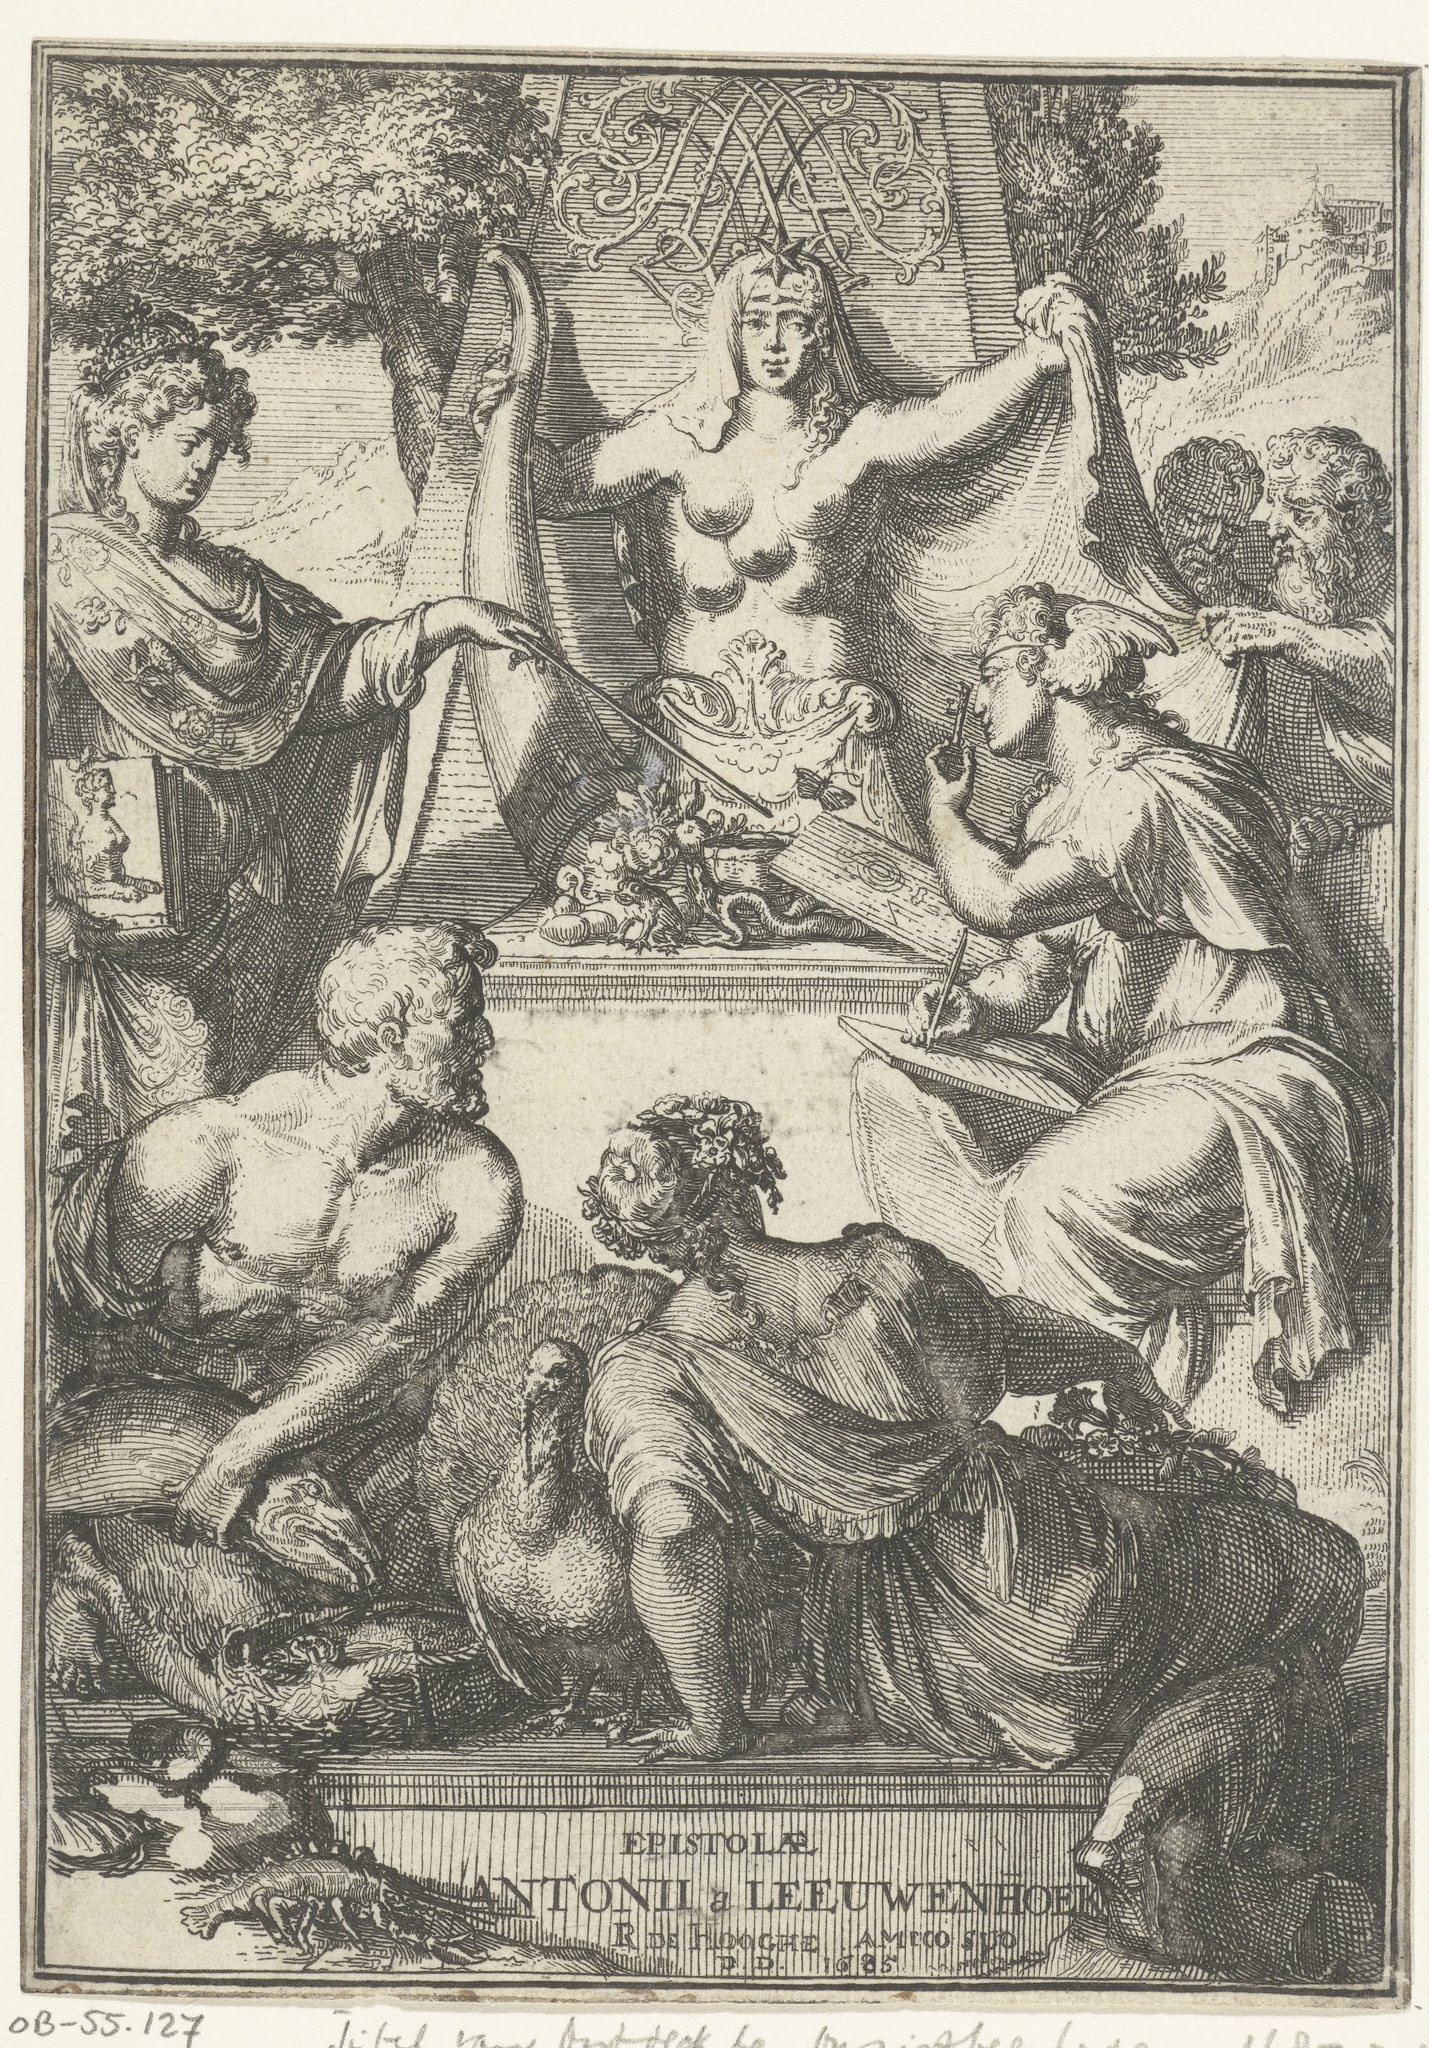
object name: print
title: Titelprent voor 'Epistolae' [= 'Ontledingen en ontdekkingen van levende dierkens in de teel-deelen van verscheyde dieren, vogelen en visschen (...) tot Londen in Engeland' of 'Anatomia seu Interiora rerum, (...) ulteriore dilucidatione epistolis'?] van Antonie van Leeuwenhoek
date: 1685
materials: paper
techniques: etching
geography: haarlem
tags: 'natura' (allegorical figure or scene; or as diana of ephesus, with many breasts); 'natura' (ripa), 'cornucopia', horn of plenty, (story of) diana (artemis)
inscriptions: date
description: Titelprent voor: Antonie van Leeuwenhoek, 'Epistolae' [= 'Ontledingen en ontdekkingen van levende dierkens in de teel-deelen van verscheyde dieren, vogelen en visschen ... tot Londen in Engeland' (Leiden: Cornelis Boutesteyn, 1686) of 'Anatomia seu Interiora rerum, ... ulteriore dilucidatione epistolis' (Leiden: Cornelis Boutesteyn, 1687)?]. Klinkert, C.